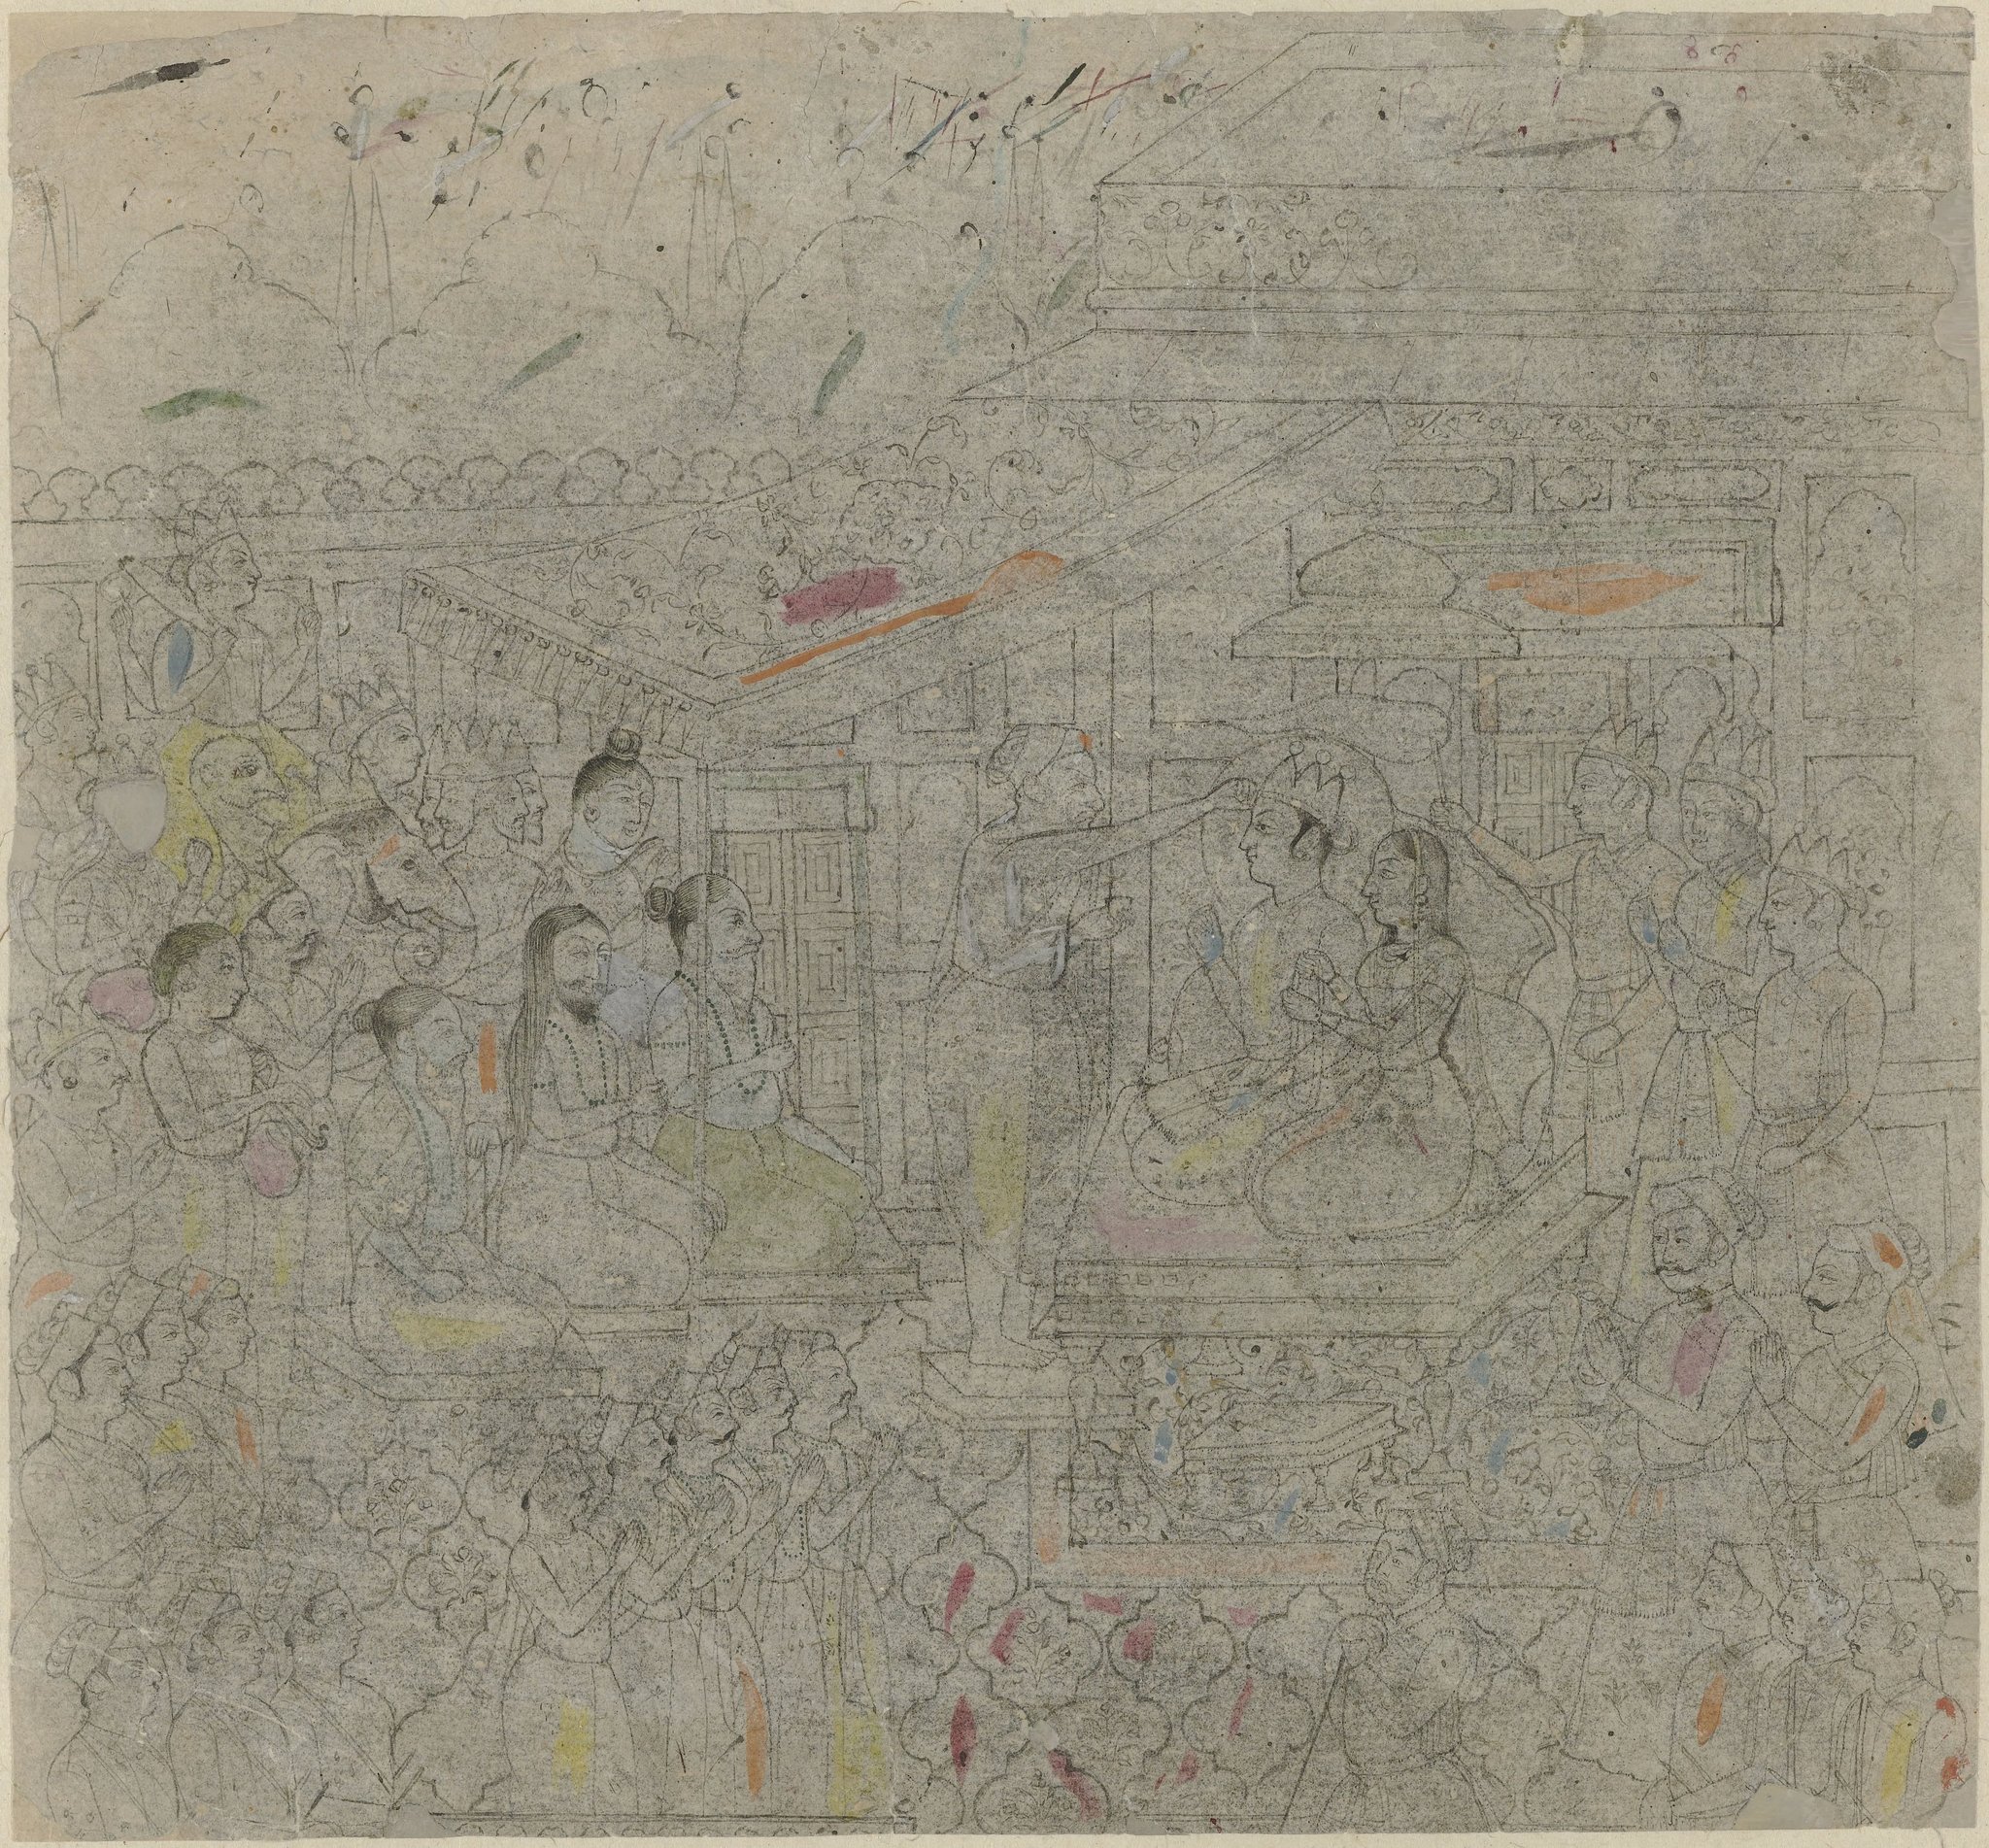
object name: drawing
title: De kroning van Rama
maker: Anonymous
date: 1800-1899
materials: paper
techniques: brush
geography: kangra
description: Gestileerde modeltekening met de priester die het huwelijk inzegent in het midden, het huwelijkspaar rechts van het midden onder een baldakijn en de genodigden links; links onder nog een paar rijen halve figuren met gevouwen handen en rechtsonder drie halve figuren en een man leunend op een stok. De modeltekening is doorgeprikt en hier en daar voorzien van likjes kleur in geel, oranje, rood, blauw en enig groen.